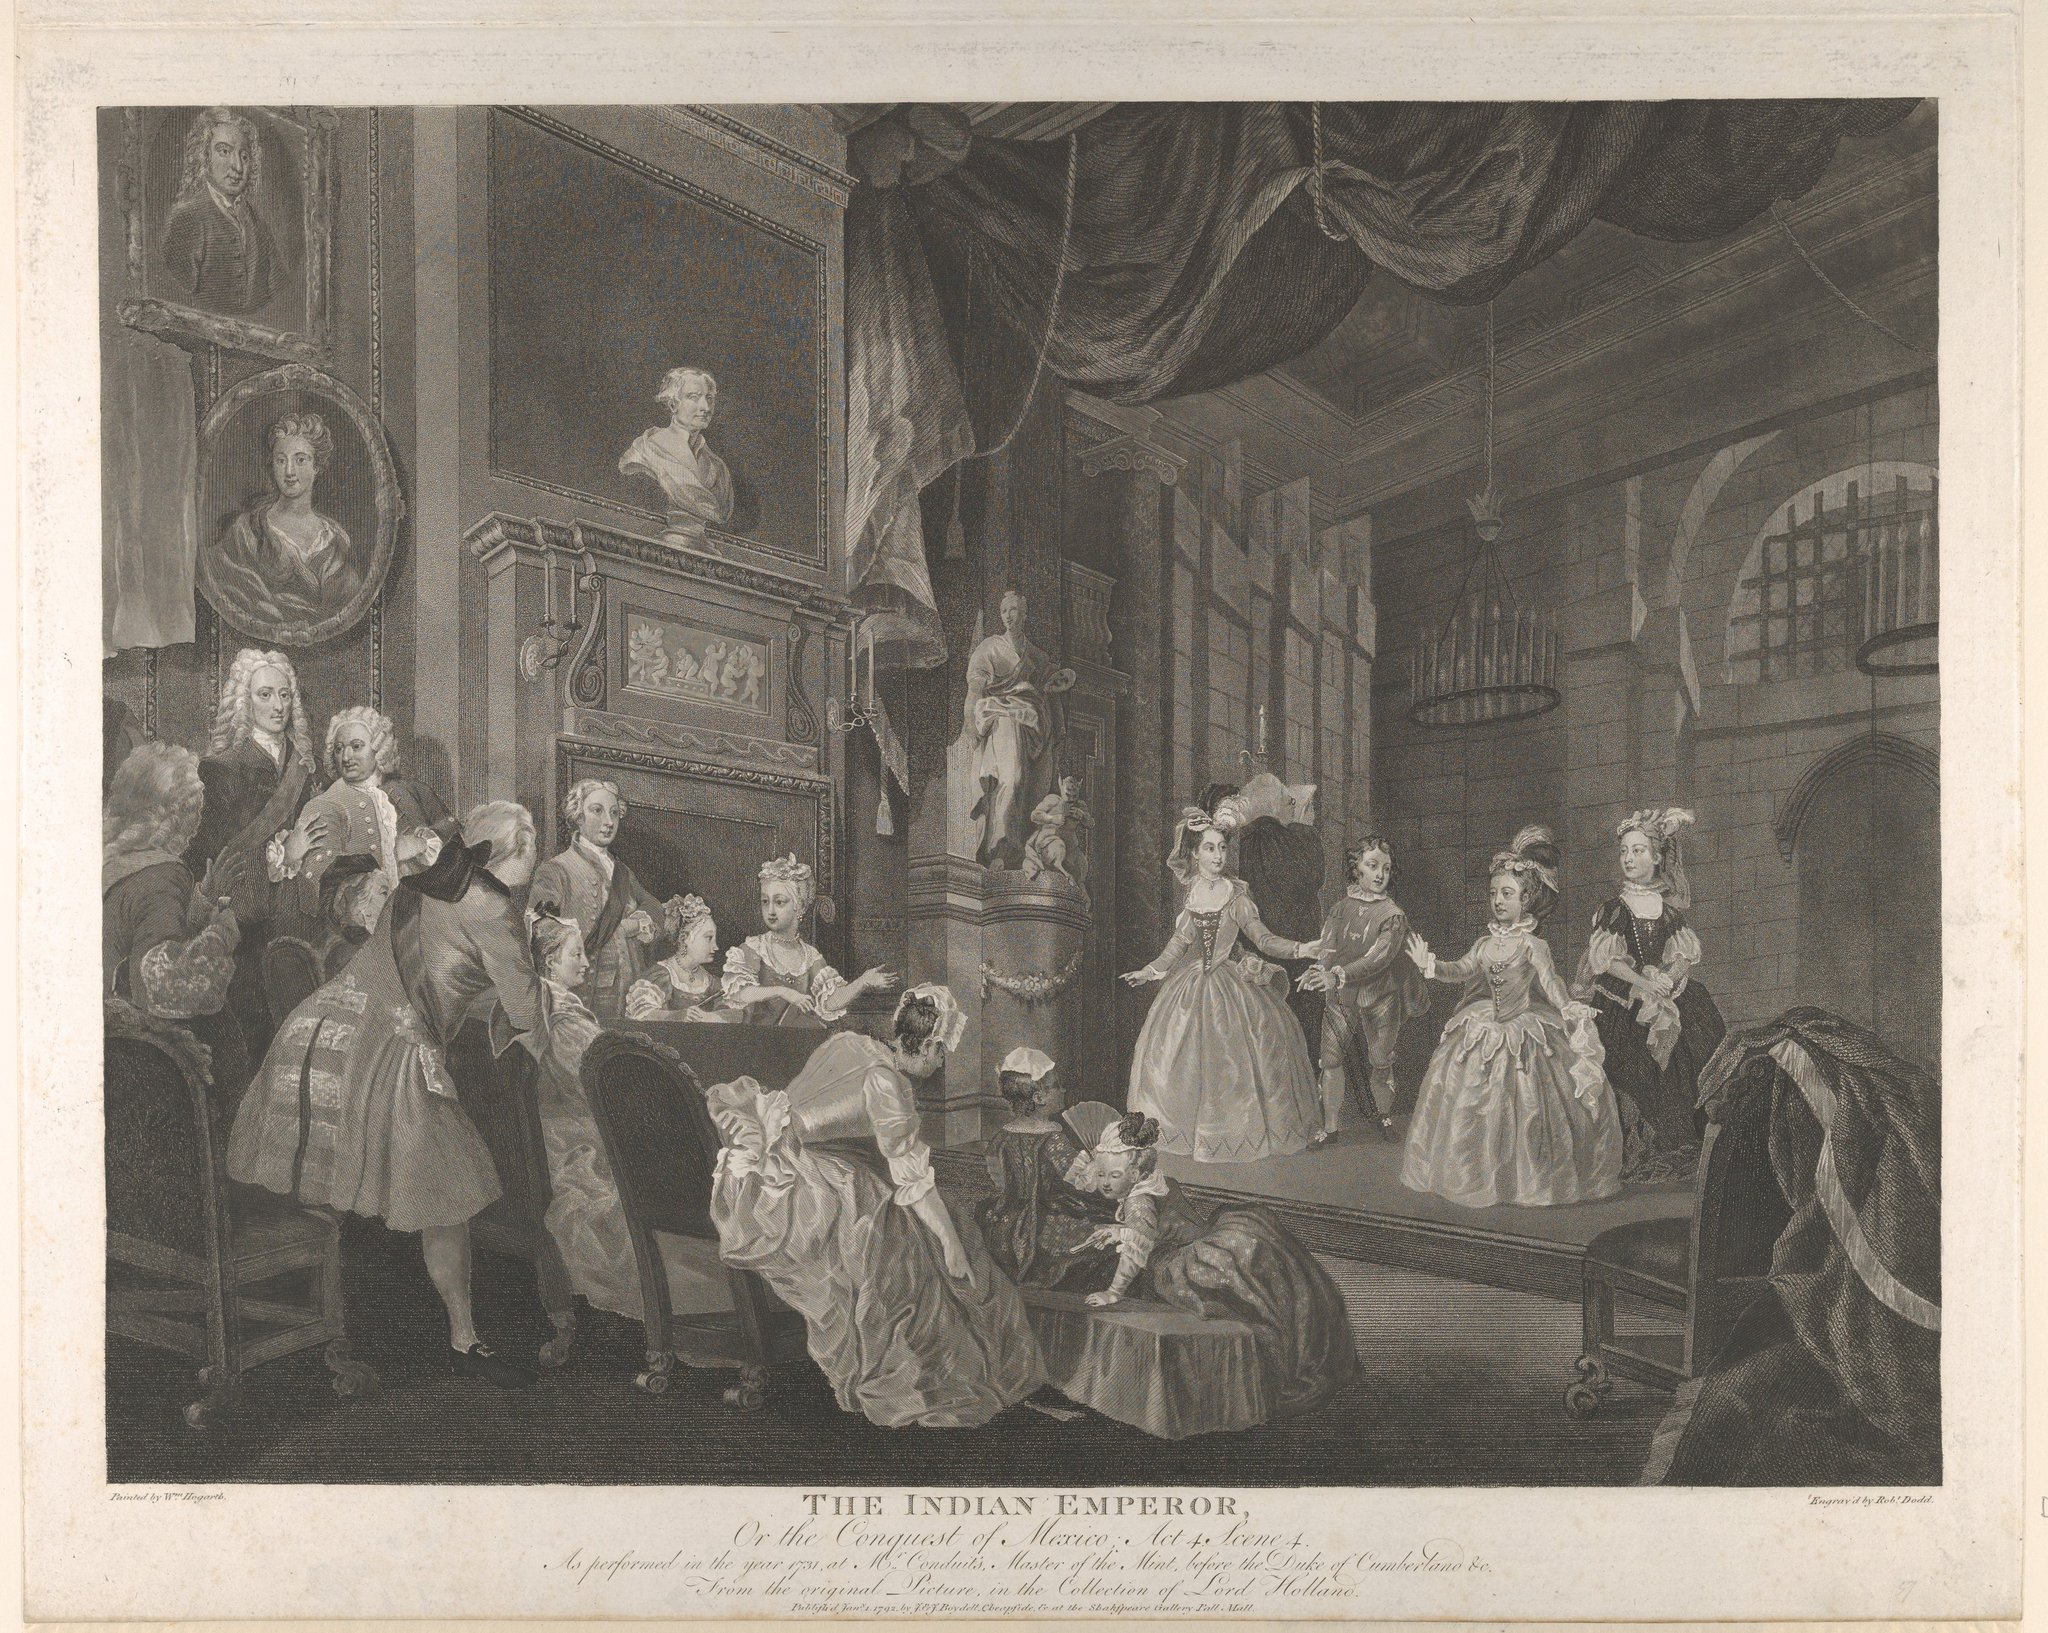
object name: print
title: The Indian Emperor, or, The Conquest of Mexico, Act 4, scene 4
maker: robert dodd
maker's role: engraver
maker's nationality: british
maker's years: 1748-1815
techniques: aquatint, etching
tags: men,women,dancing